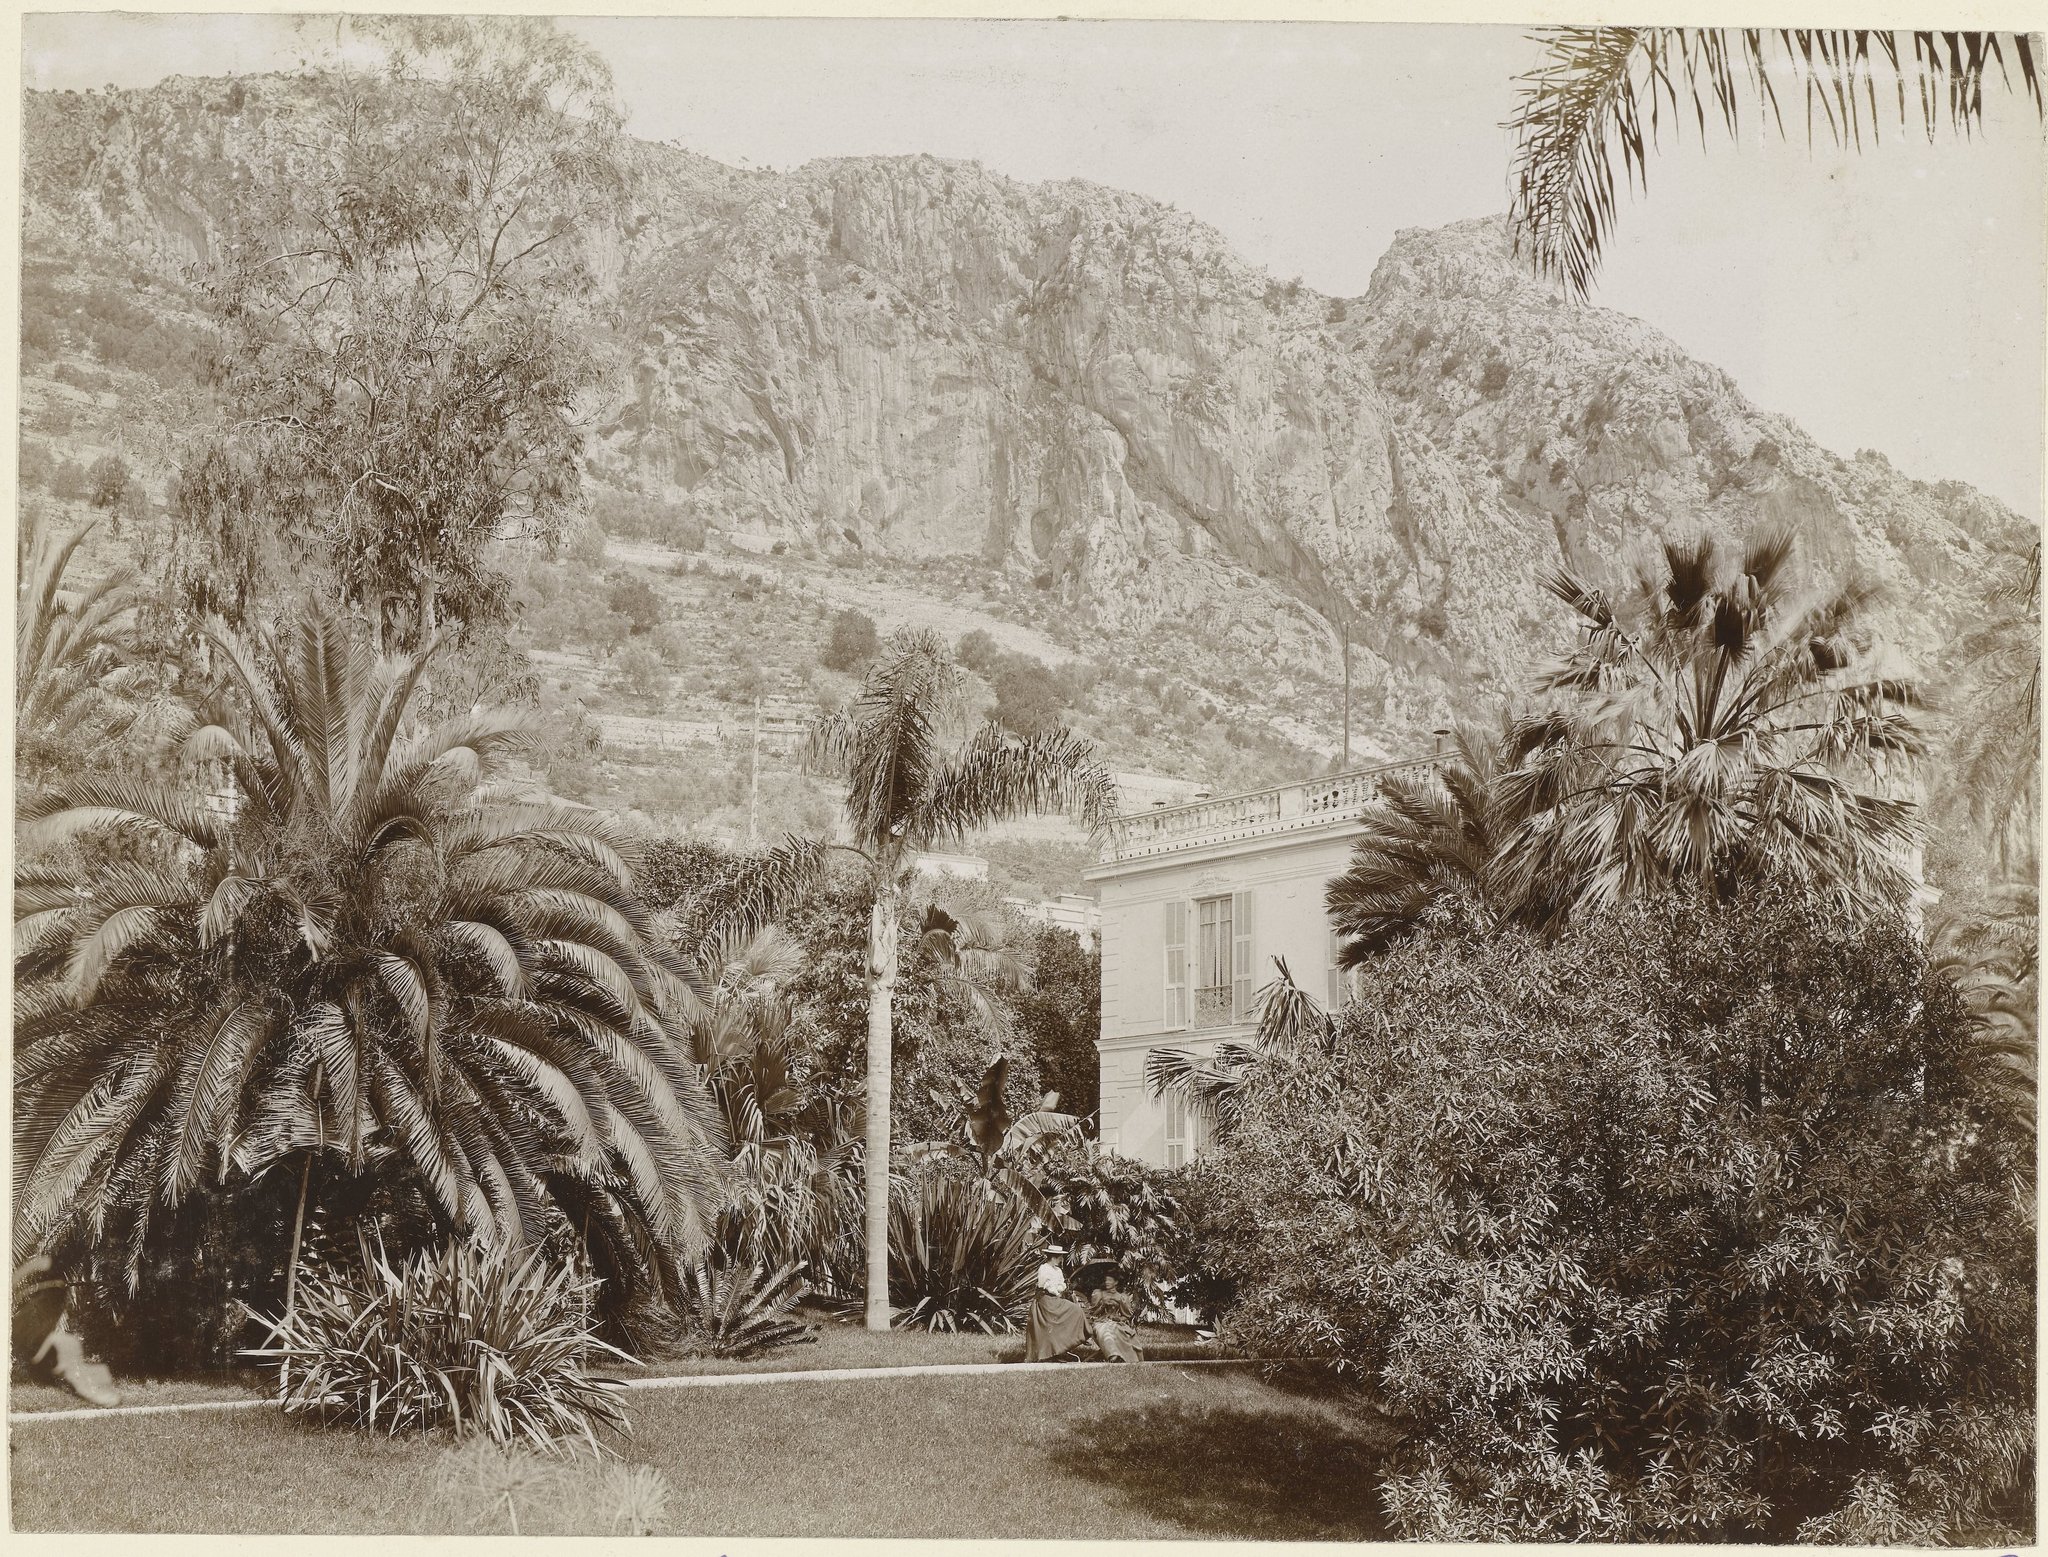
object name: photograph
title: Villa Chauvassaignes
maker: henry pauw van wieldrecht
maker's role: fotograaf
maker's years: 1863-1912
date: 1886-1896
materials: cardboard, photographic support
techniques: albumen print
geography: france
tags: menton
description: Villa Chauvassaignes met de tuin met palmen gelegen in de zuid Franse stad Menton. In de tuin aan de vijver zit een dame met een hoed. Op de achtergrond een steile rotswand.